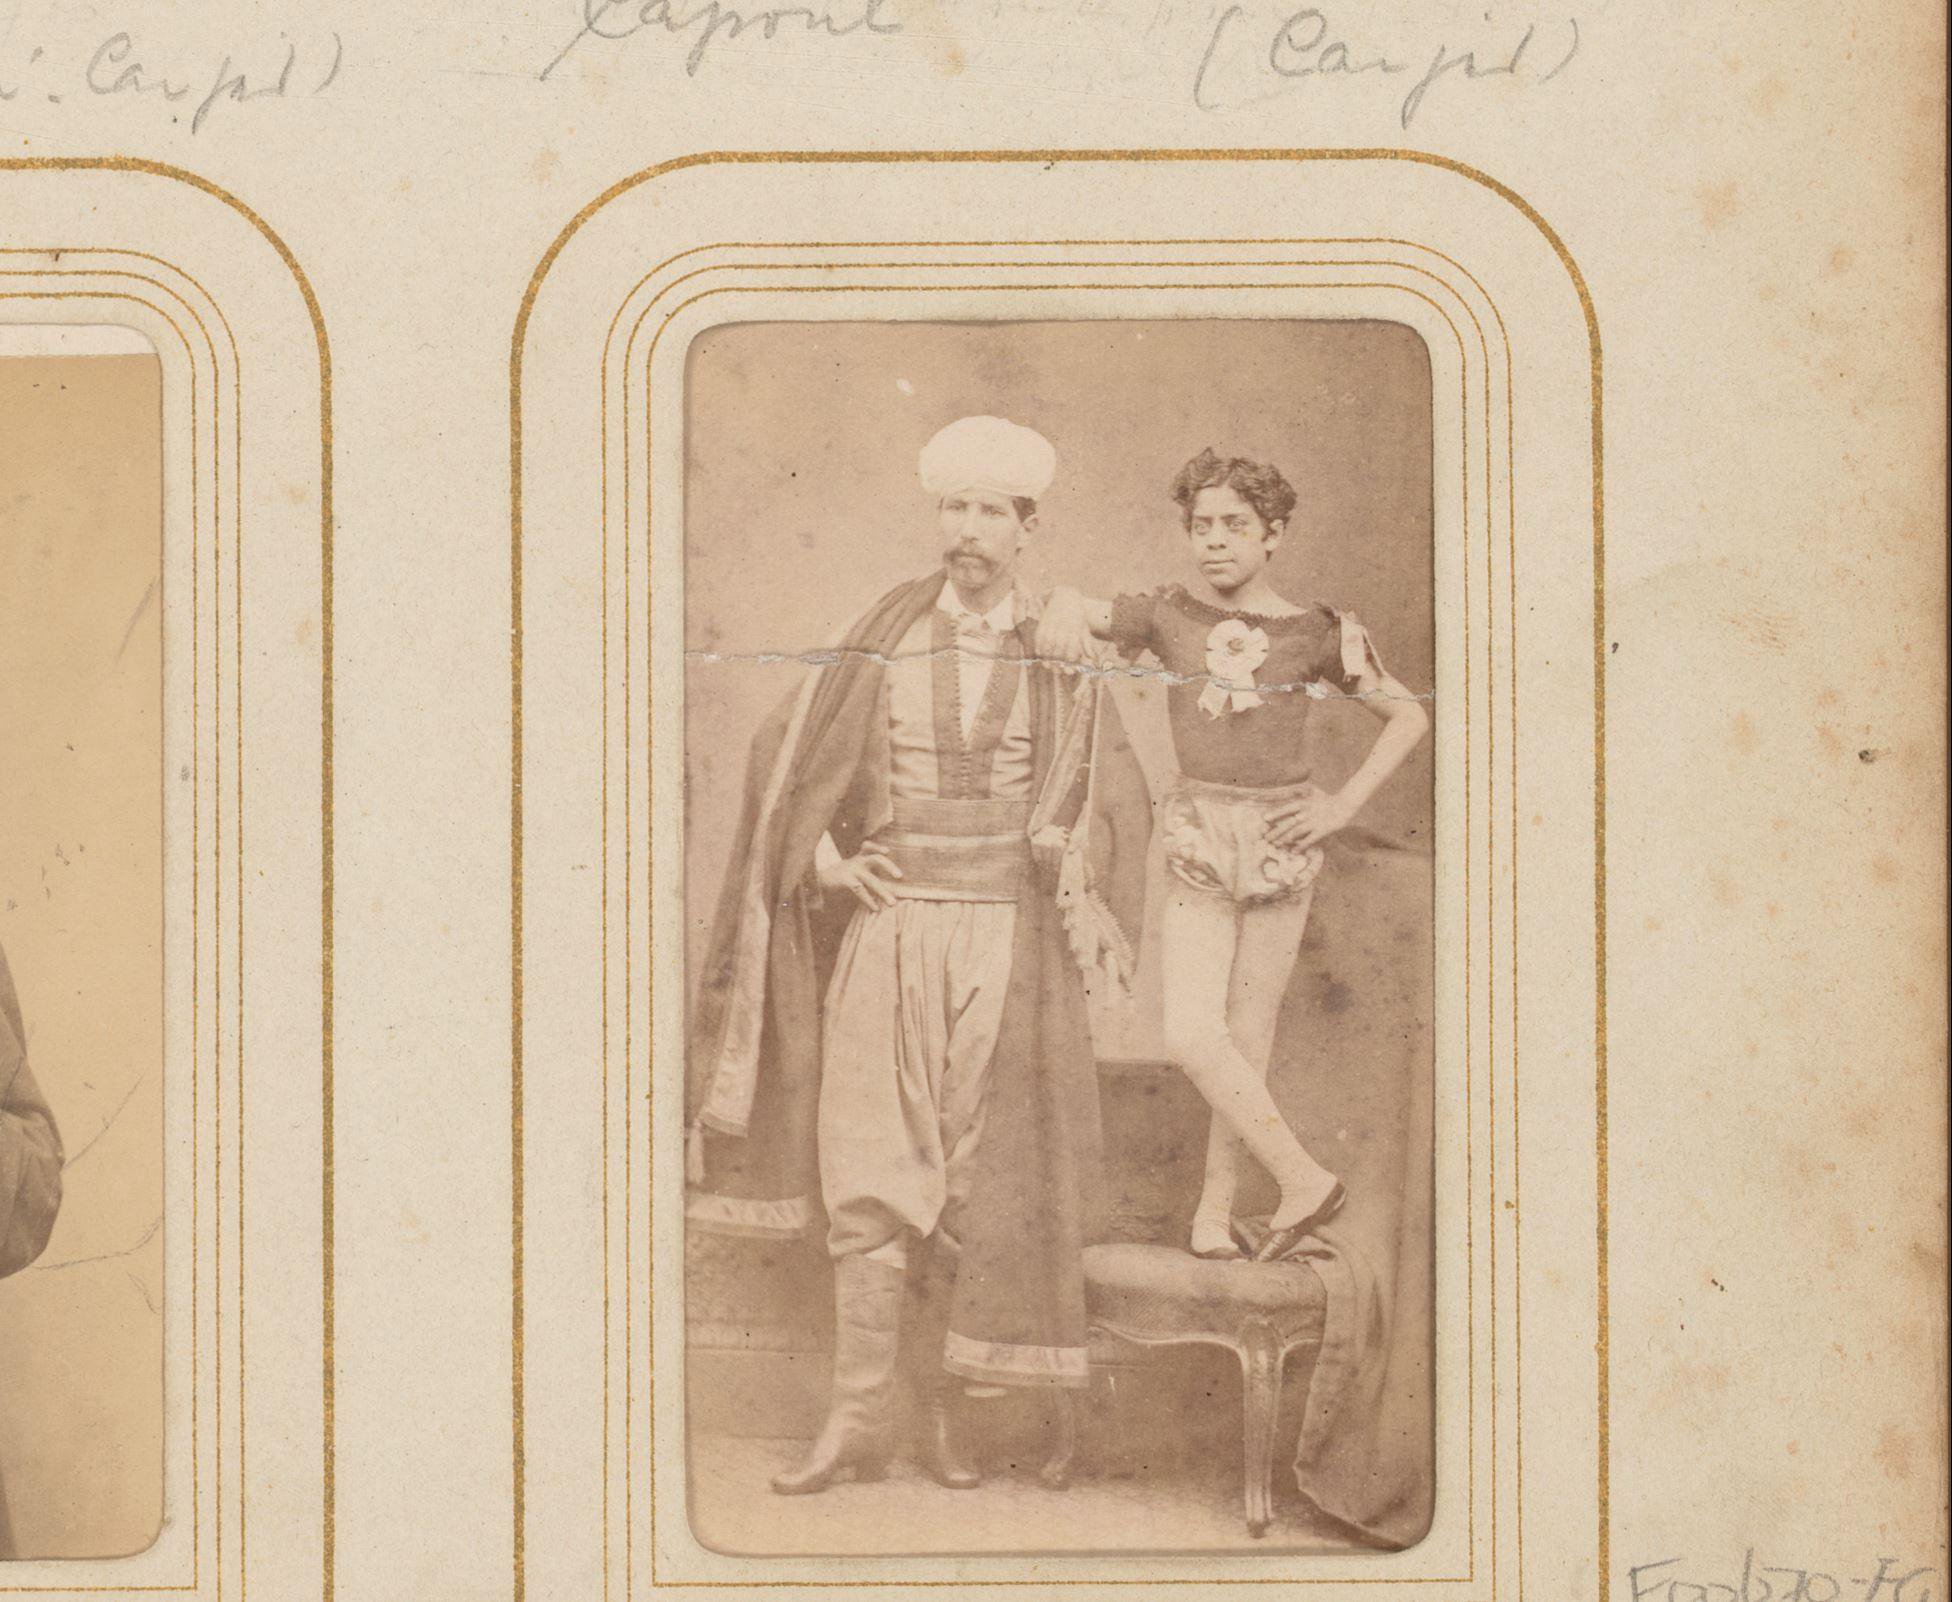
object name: photograph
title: Portret van twee artiesten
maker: arthur william burman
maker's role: fotograaf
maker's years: 1851-1915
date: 1877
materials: cardboard, photographic support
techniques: albumen print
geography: melbourne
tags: historical persons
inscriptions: inscription: ‘A.W. Burman/ Artist Photographer/ 209/ Bourke Street East’, annotation: ‘[...] 24/1/1877’